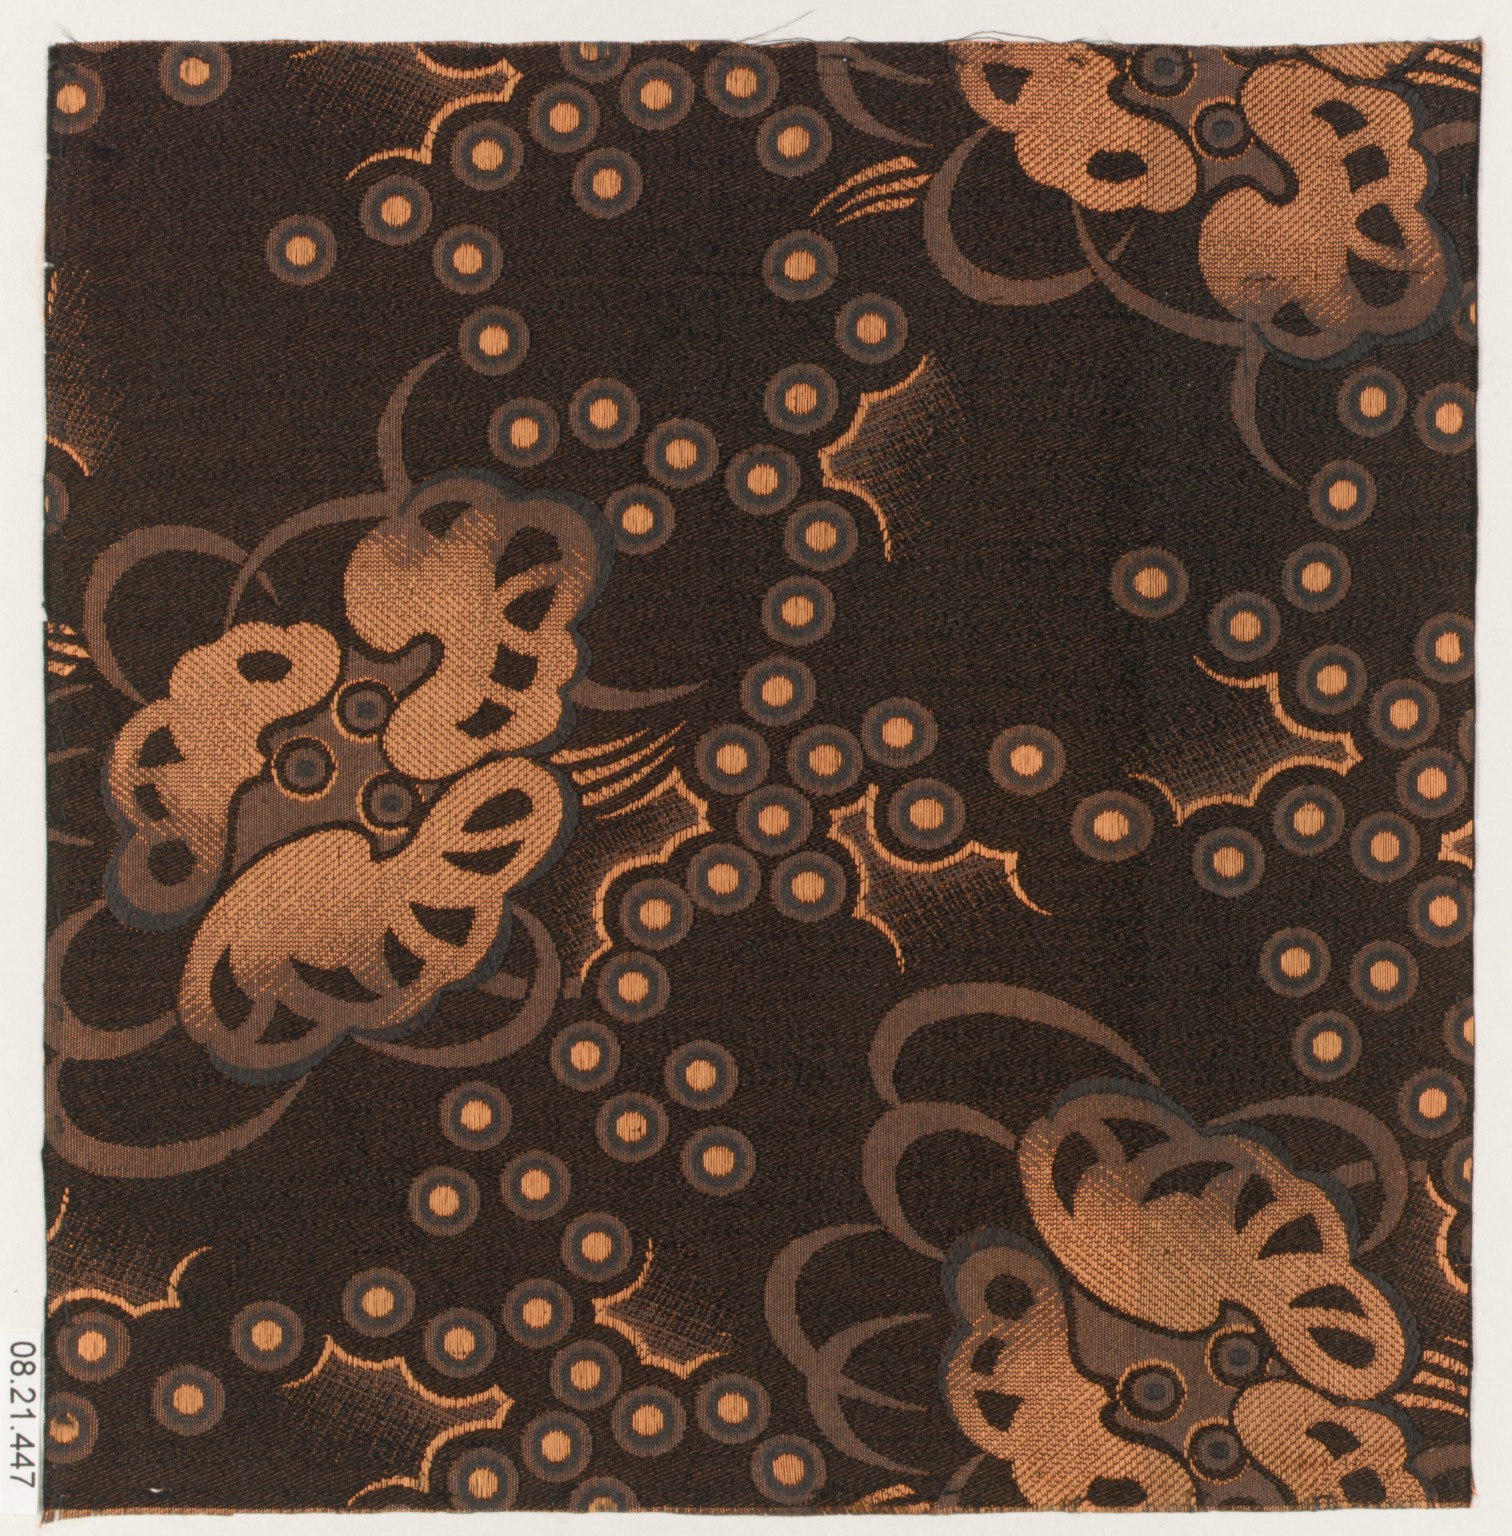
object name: textile sample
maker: Anonymous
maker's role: designer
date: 1900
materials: silk